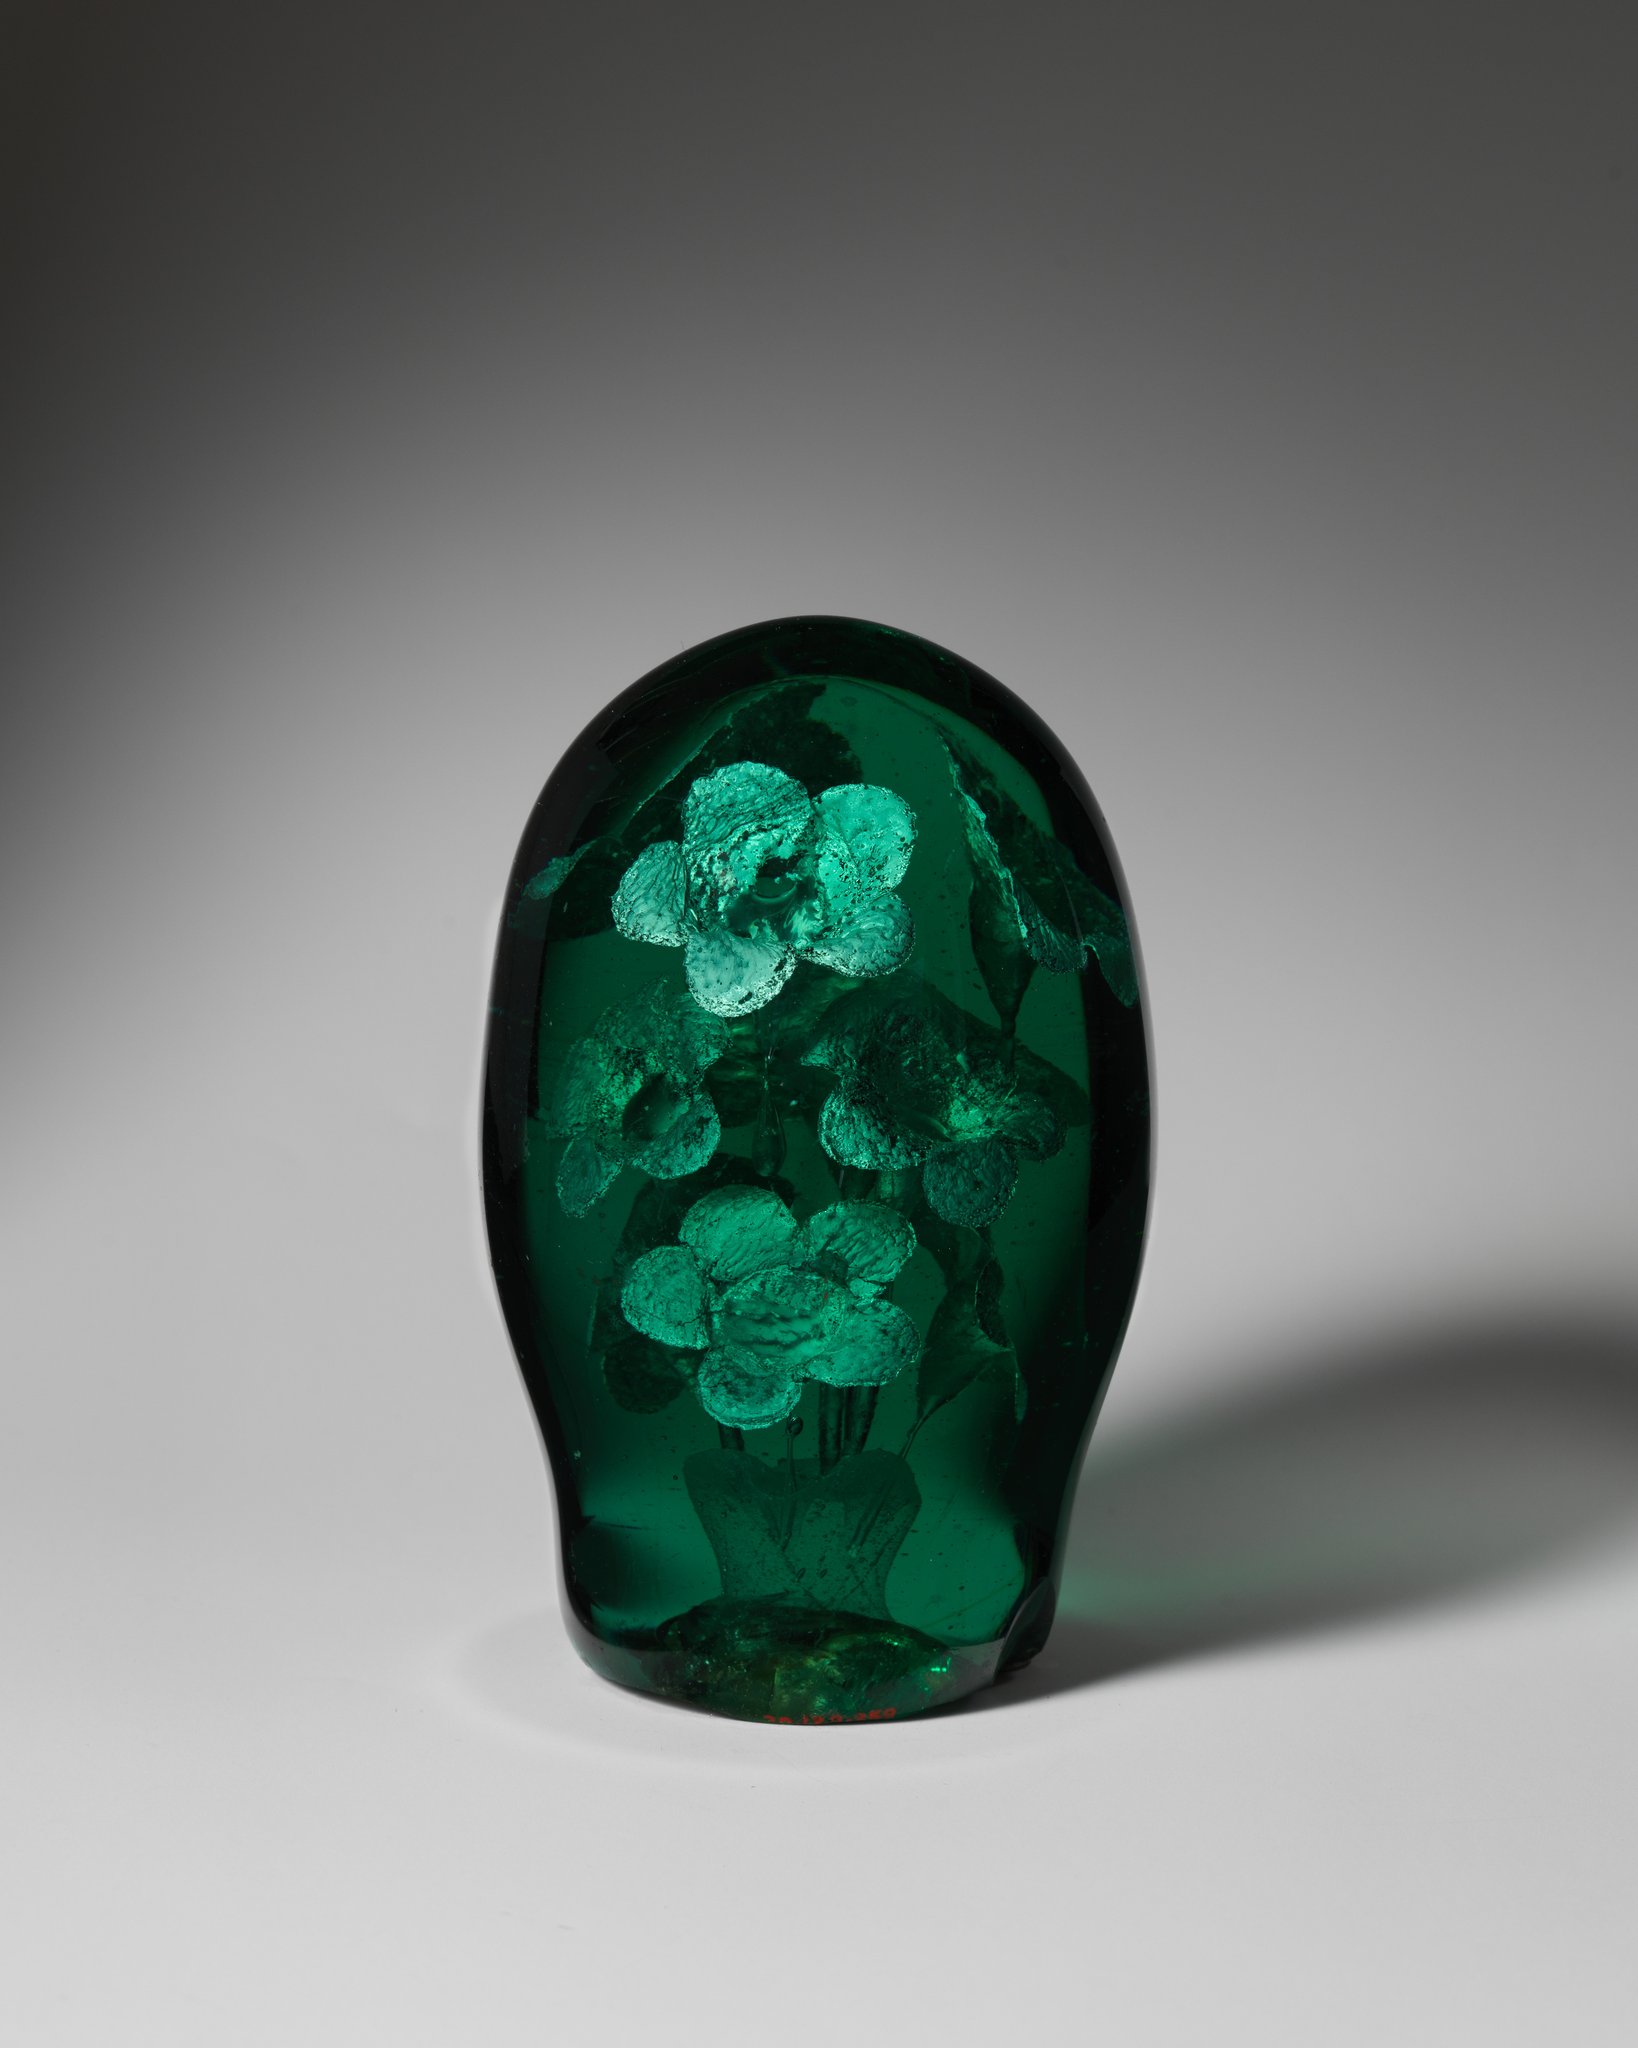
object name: door stop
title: Door stop (one of a pair)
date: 1801-1900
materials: glass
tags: flowers